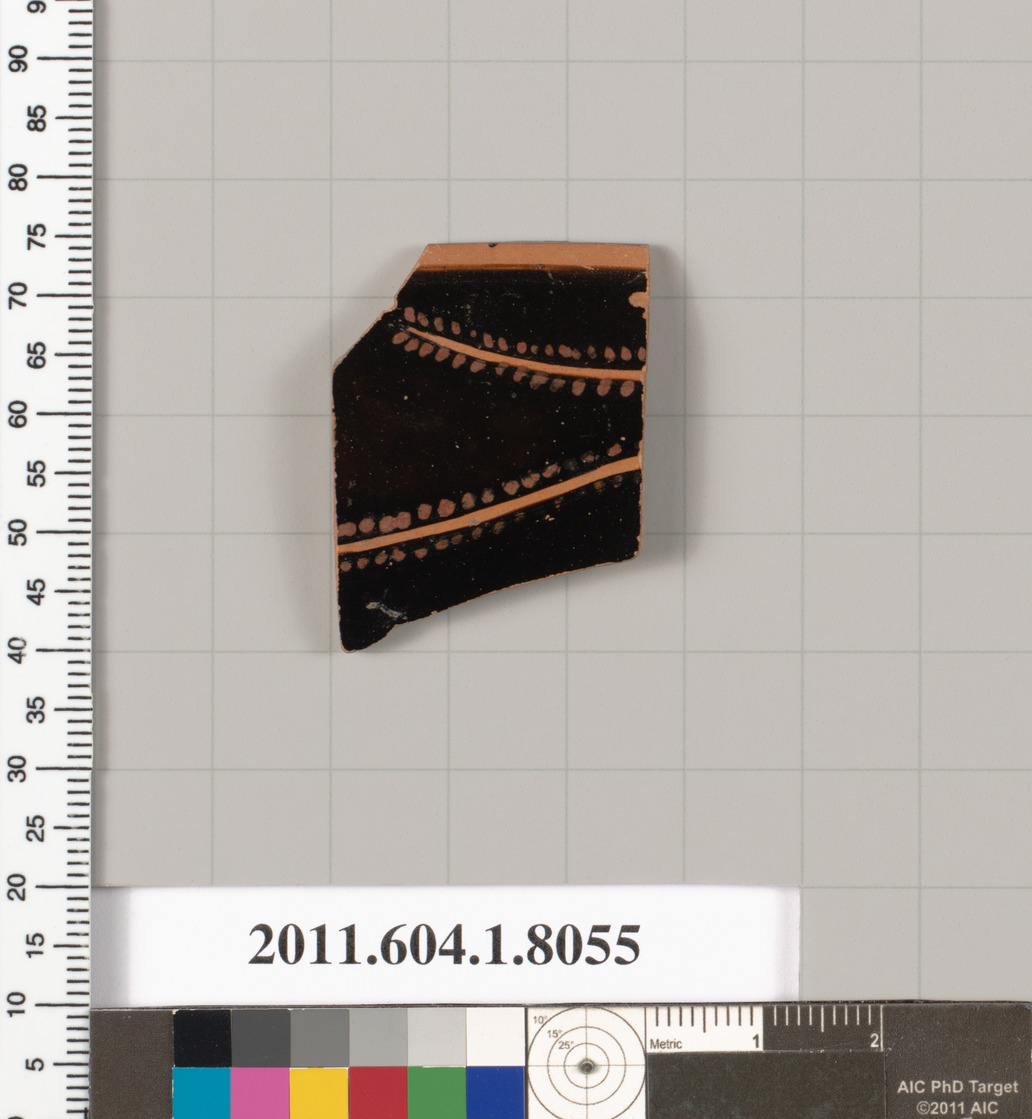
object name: kylix fragment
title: Terracotta rim fragment of a kylix (drinking cup)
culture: greek, attic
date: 510-500 BCE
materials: terracotta